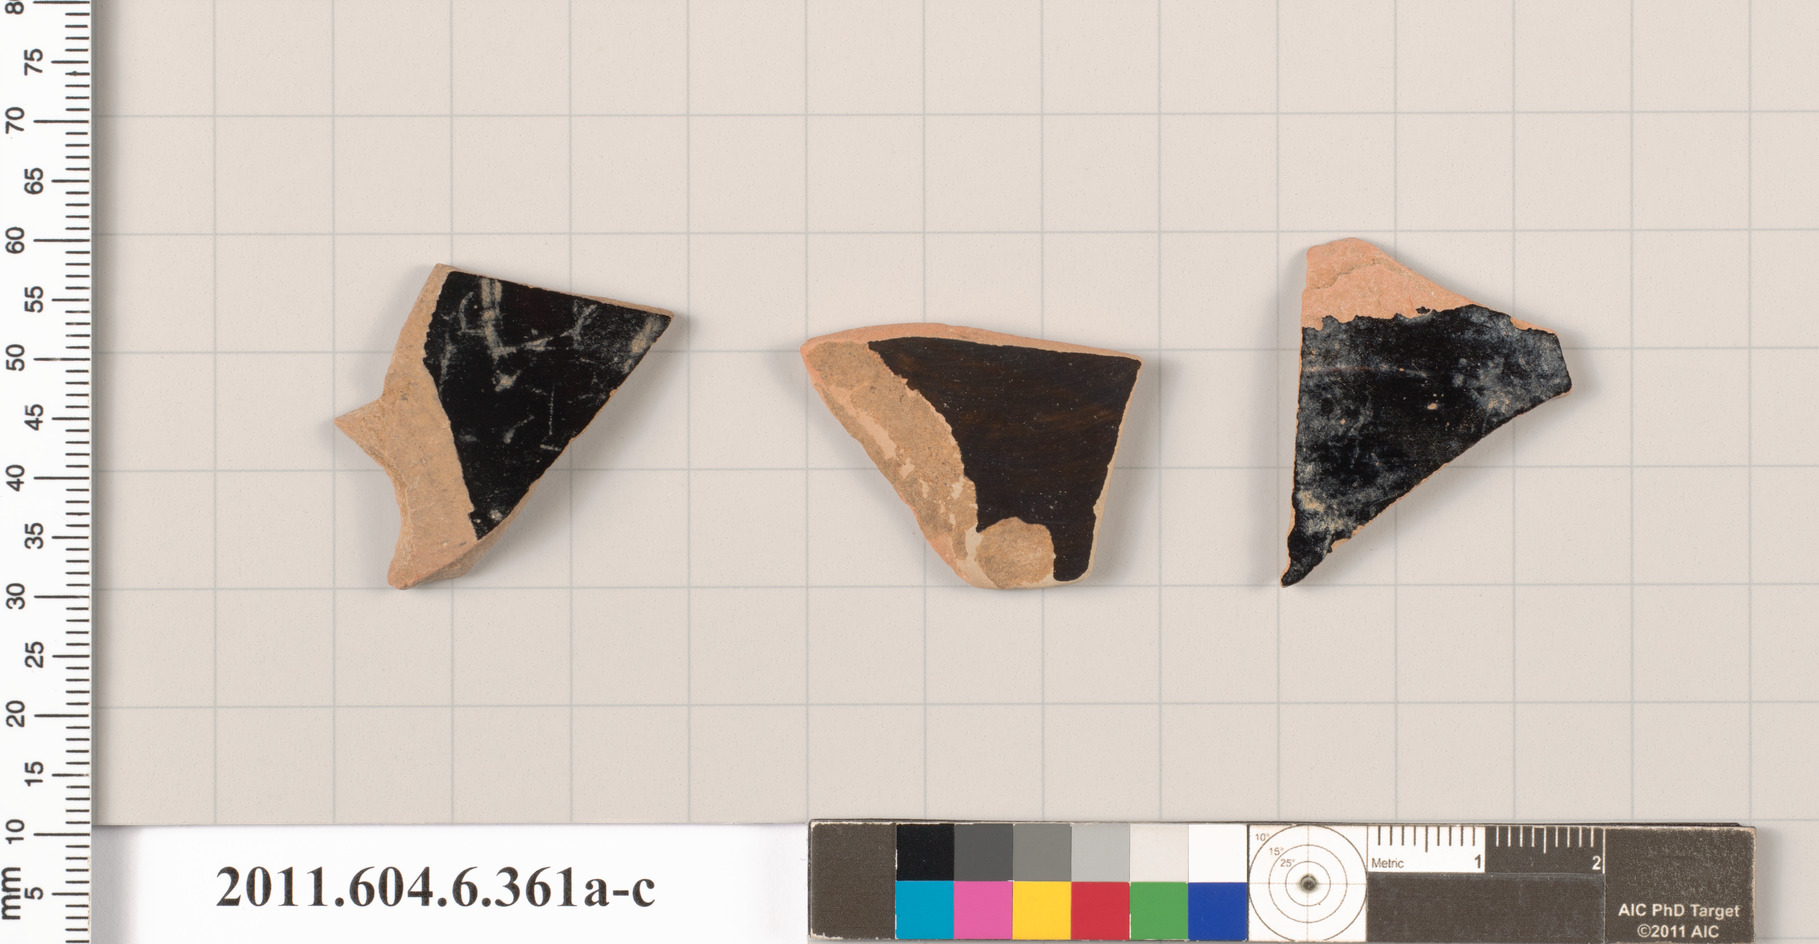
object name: undetermined closed shape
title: Terracotta fragments of closed shapes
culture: greek, attic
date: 600-401 BCE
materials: terracotta